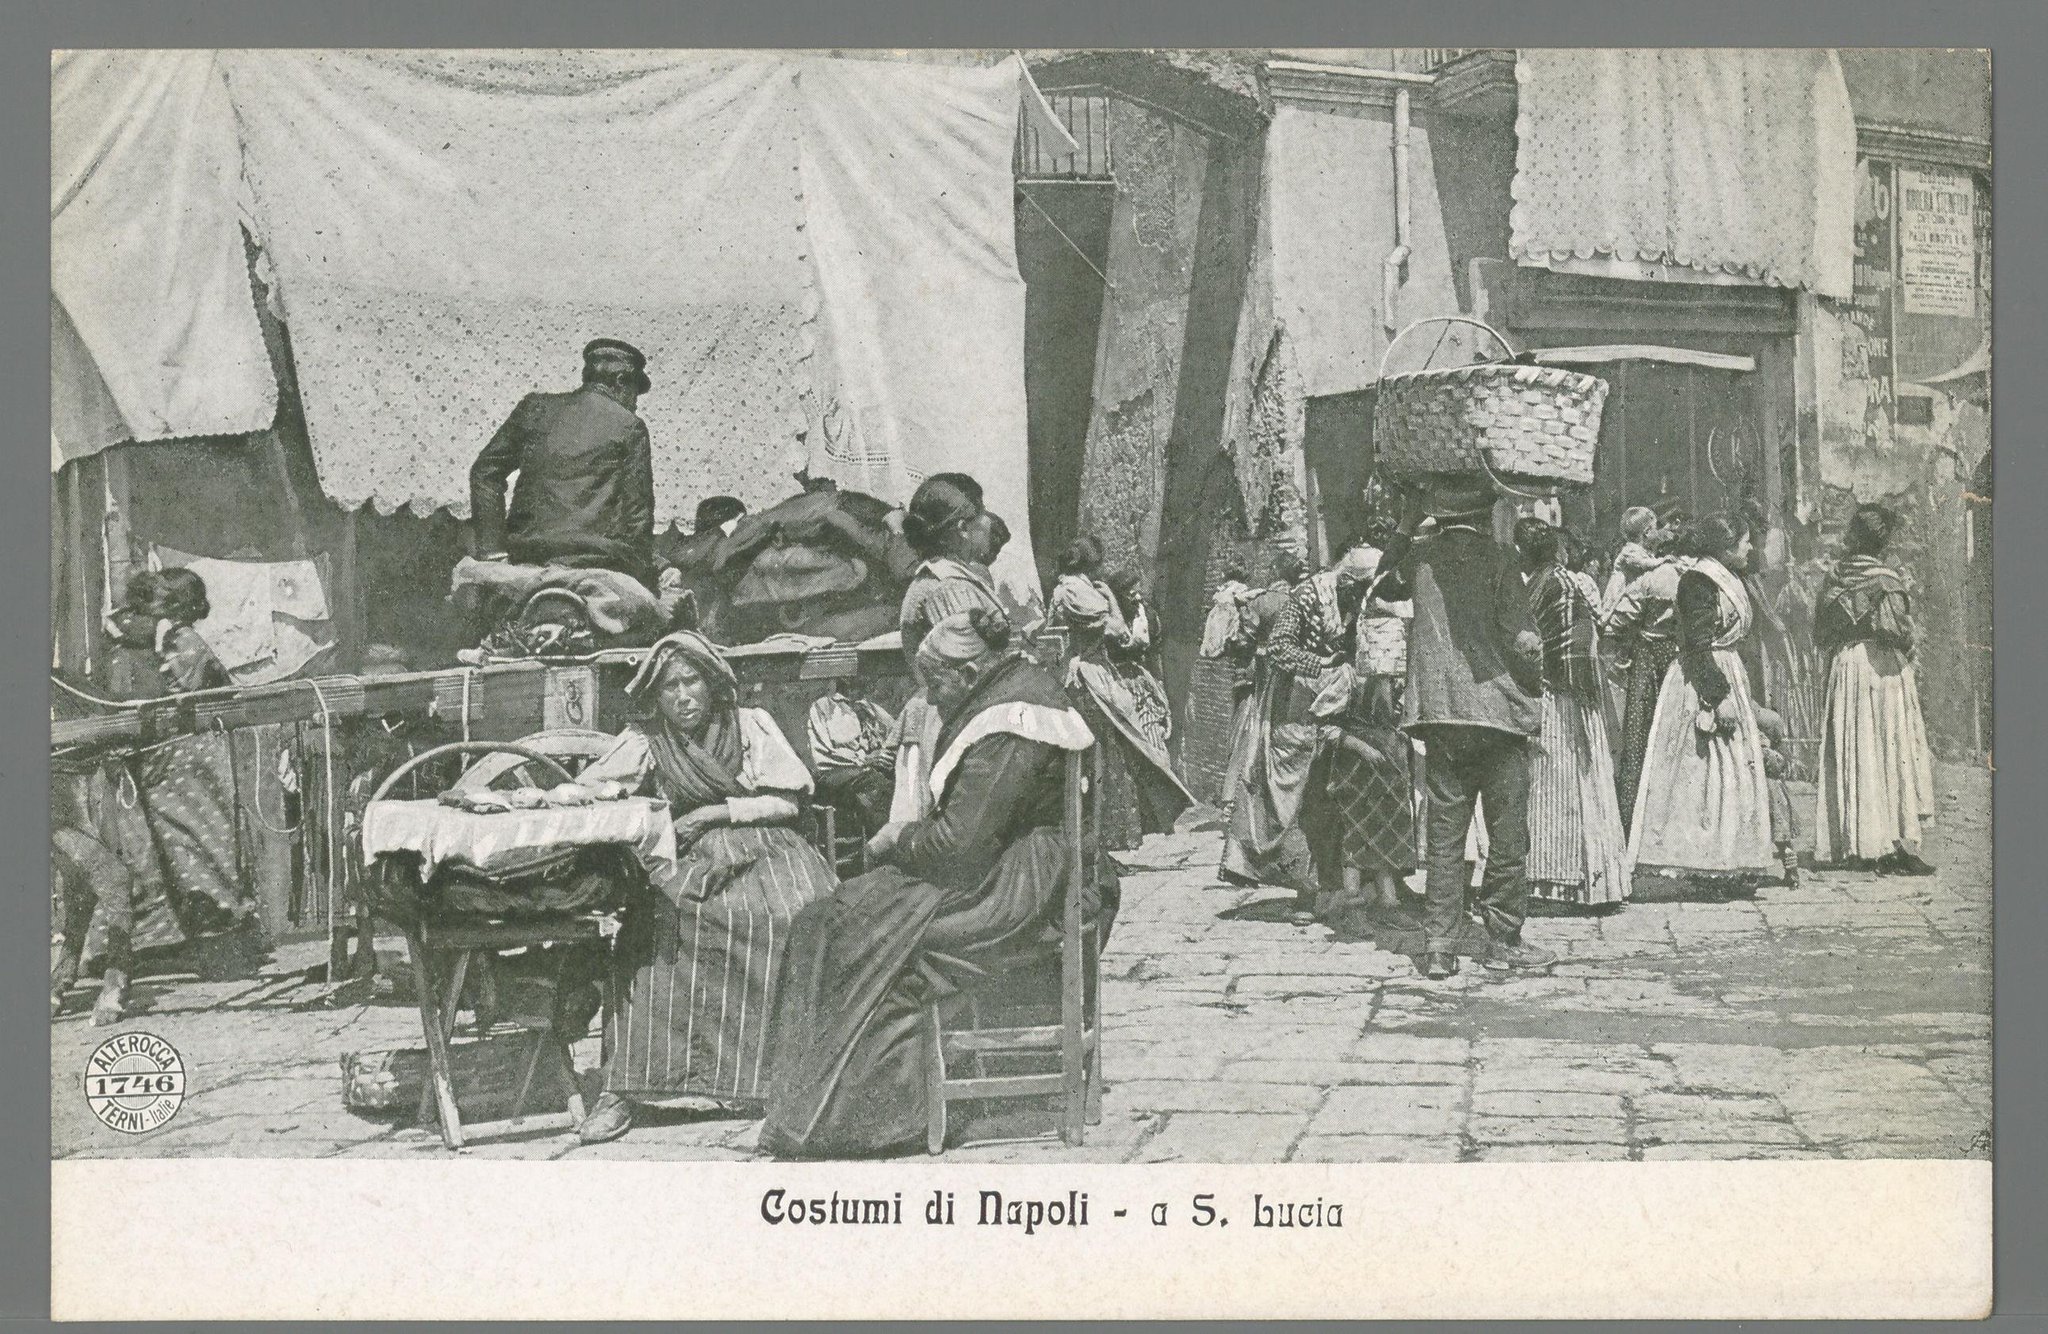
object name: photomechanical print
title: Costumi di Napoli. A S. Lucia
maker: Anonymous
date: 1906-1910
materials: cardboard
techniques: autotype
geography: camaldoli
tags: merchant, salesman - bb - women engaged in trade and commerce, market, city-view, and landscape with man-made constructions (+ city(-scape) with figures, staffage), naples